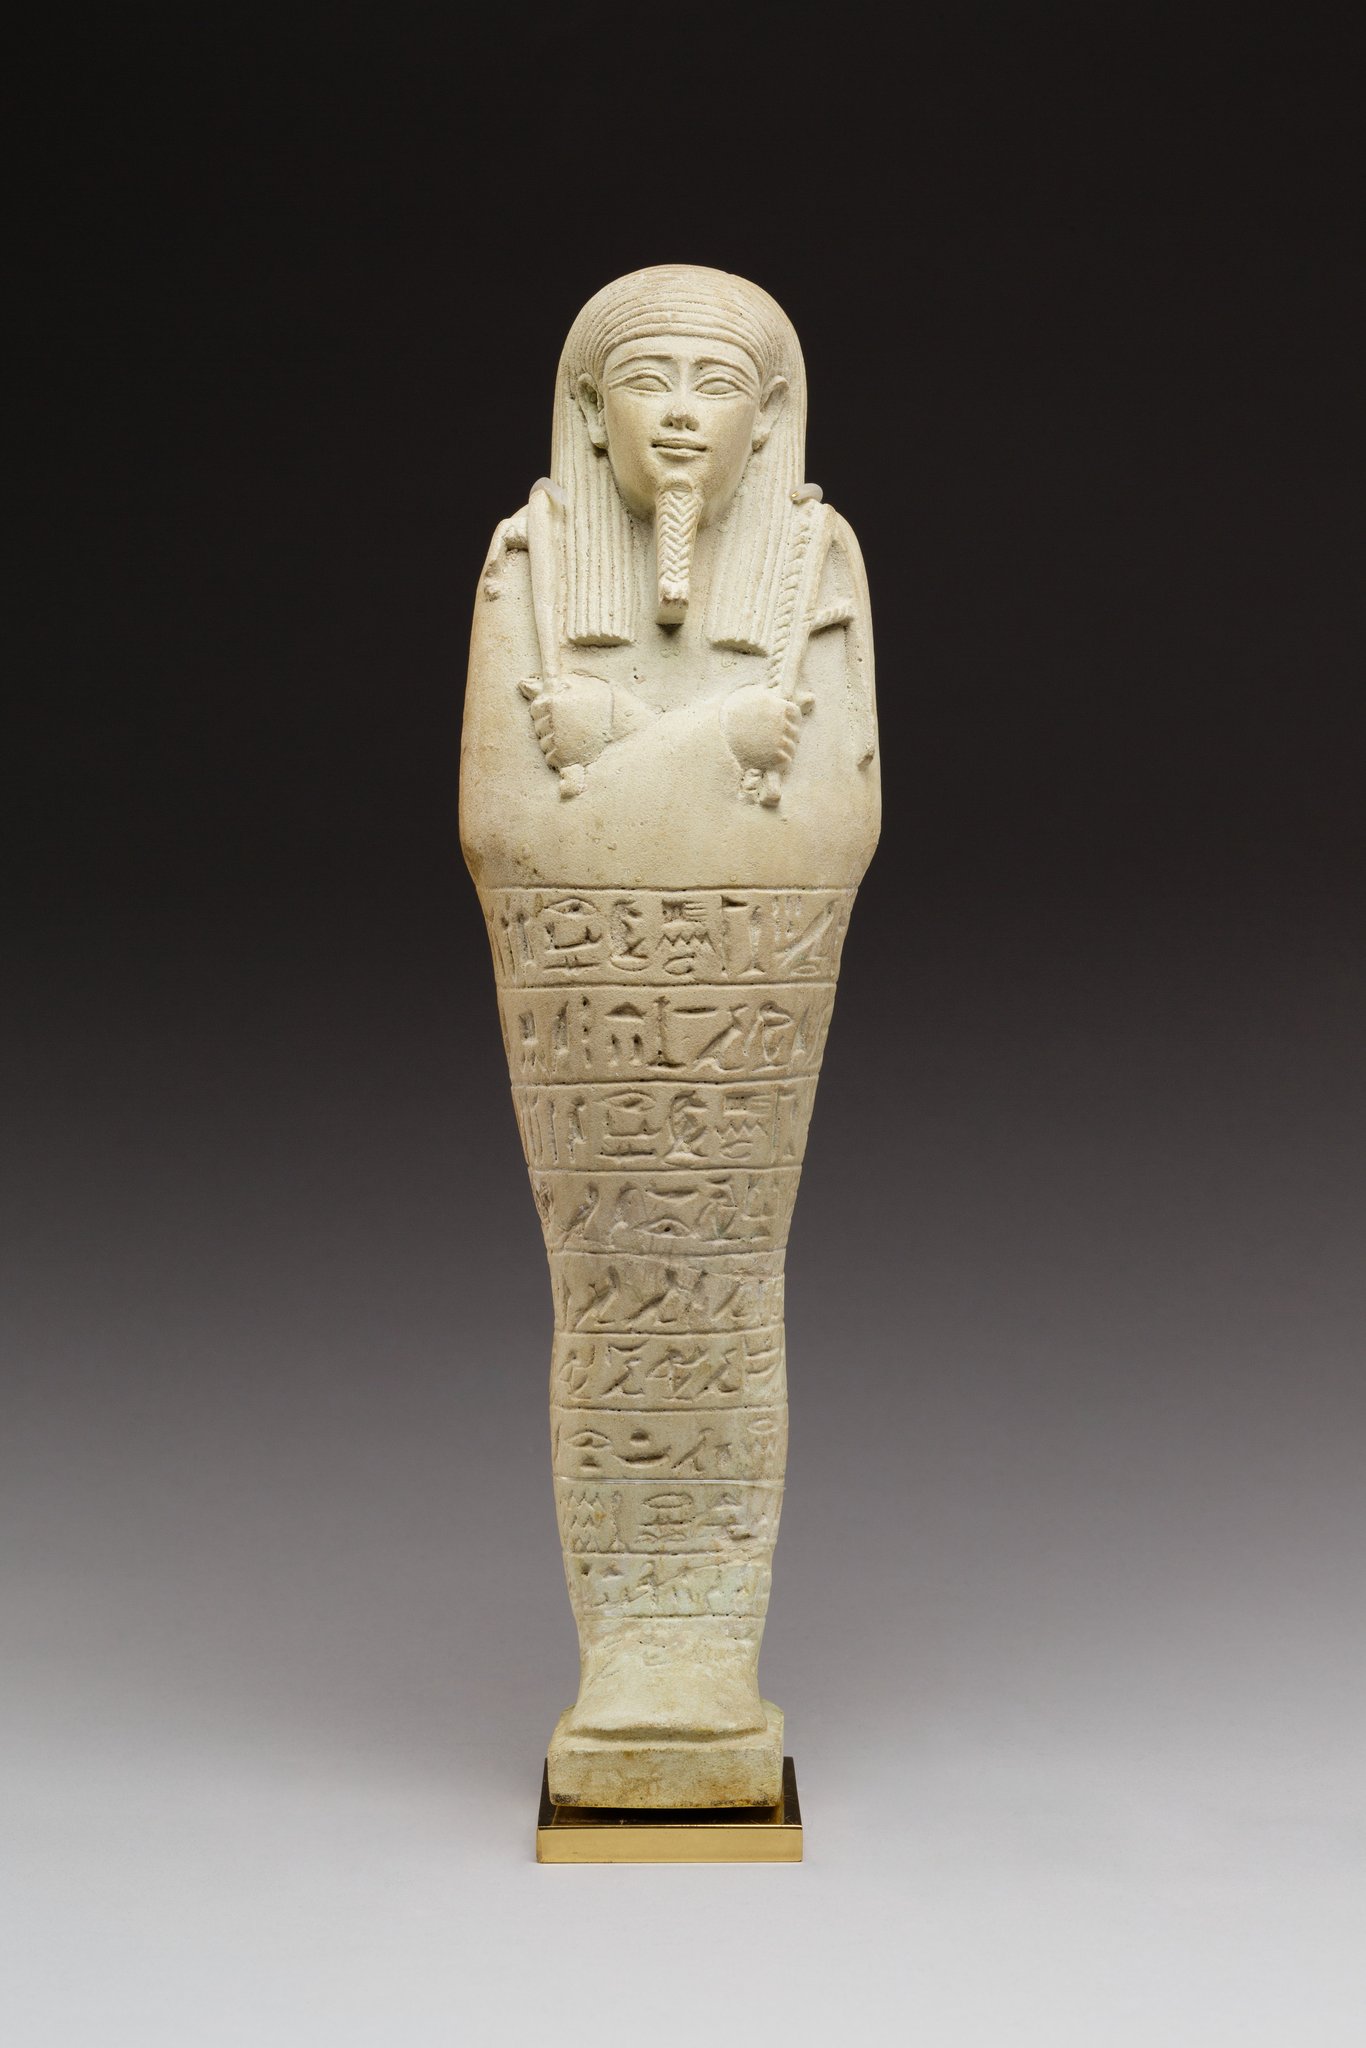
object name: shabti, priest djehutyirdis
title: Shabti of the High Priest of Thoth Djehutyirdis, born of Nepthysiti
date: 380-362 BCE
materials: faience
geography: middle egypt